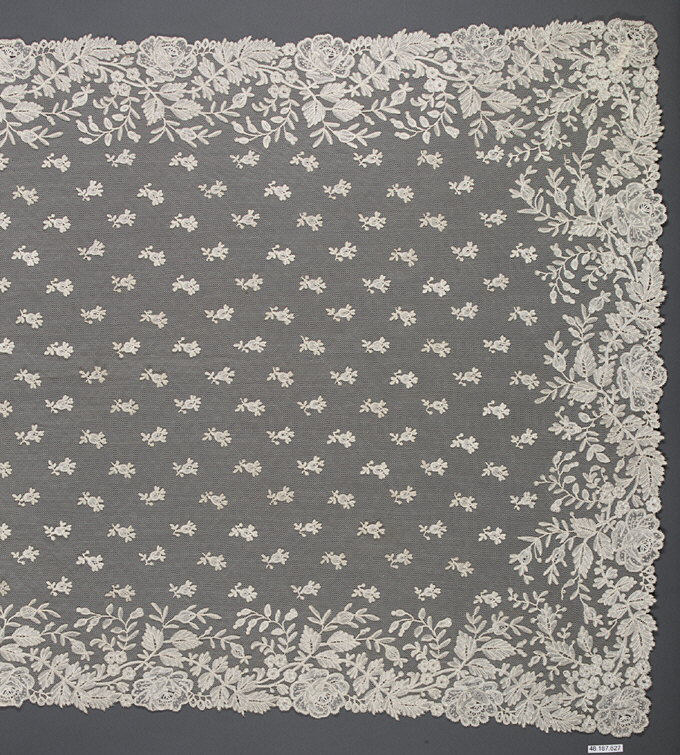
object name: border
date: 1867-1900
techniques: lace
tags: flowers